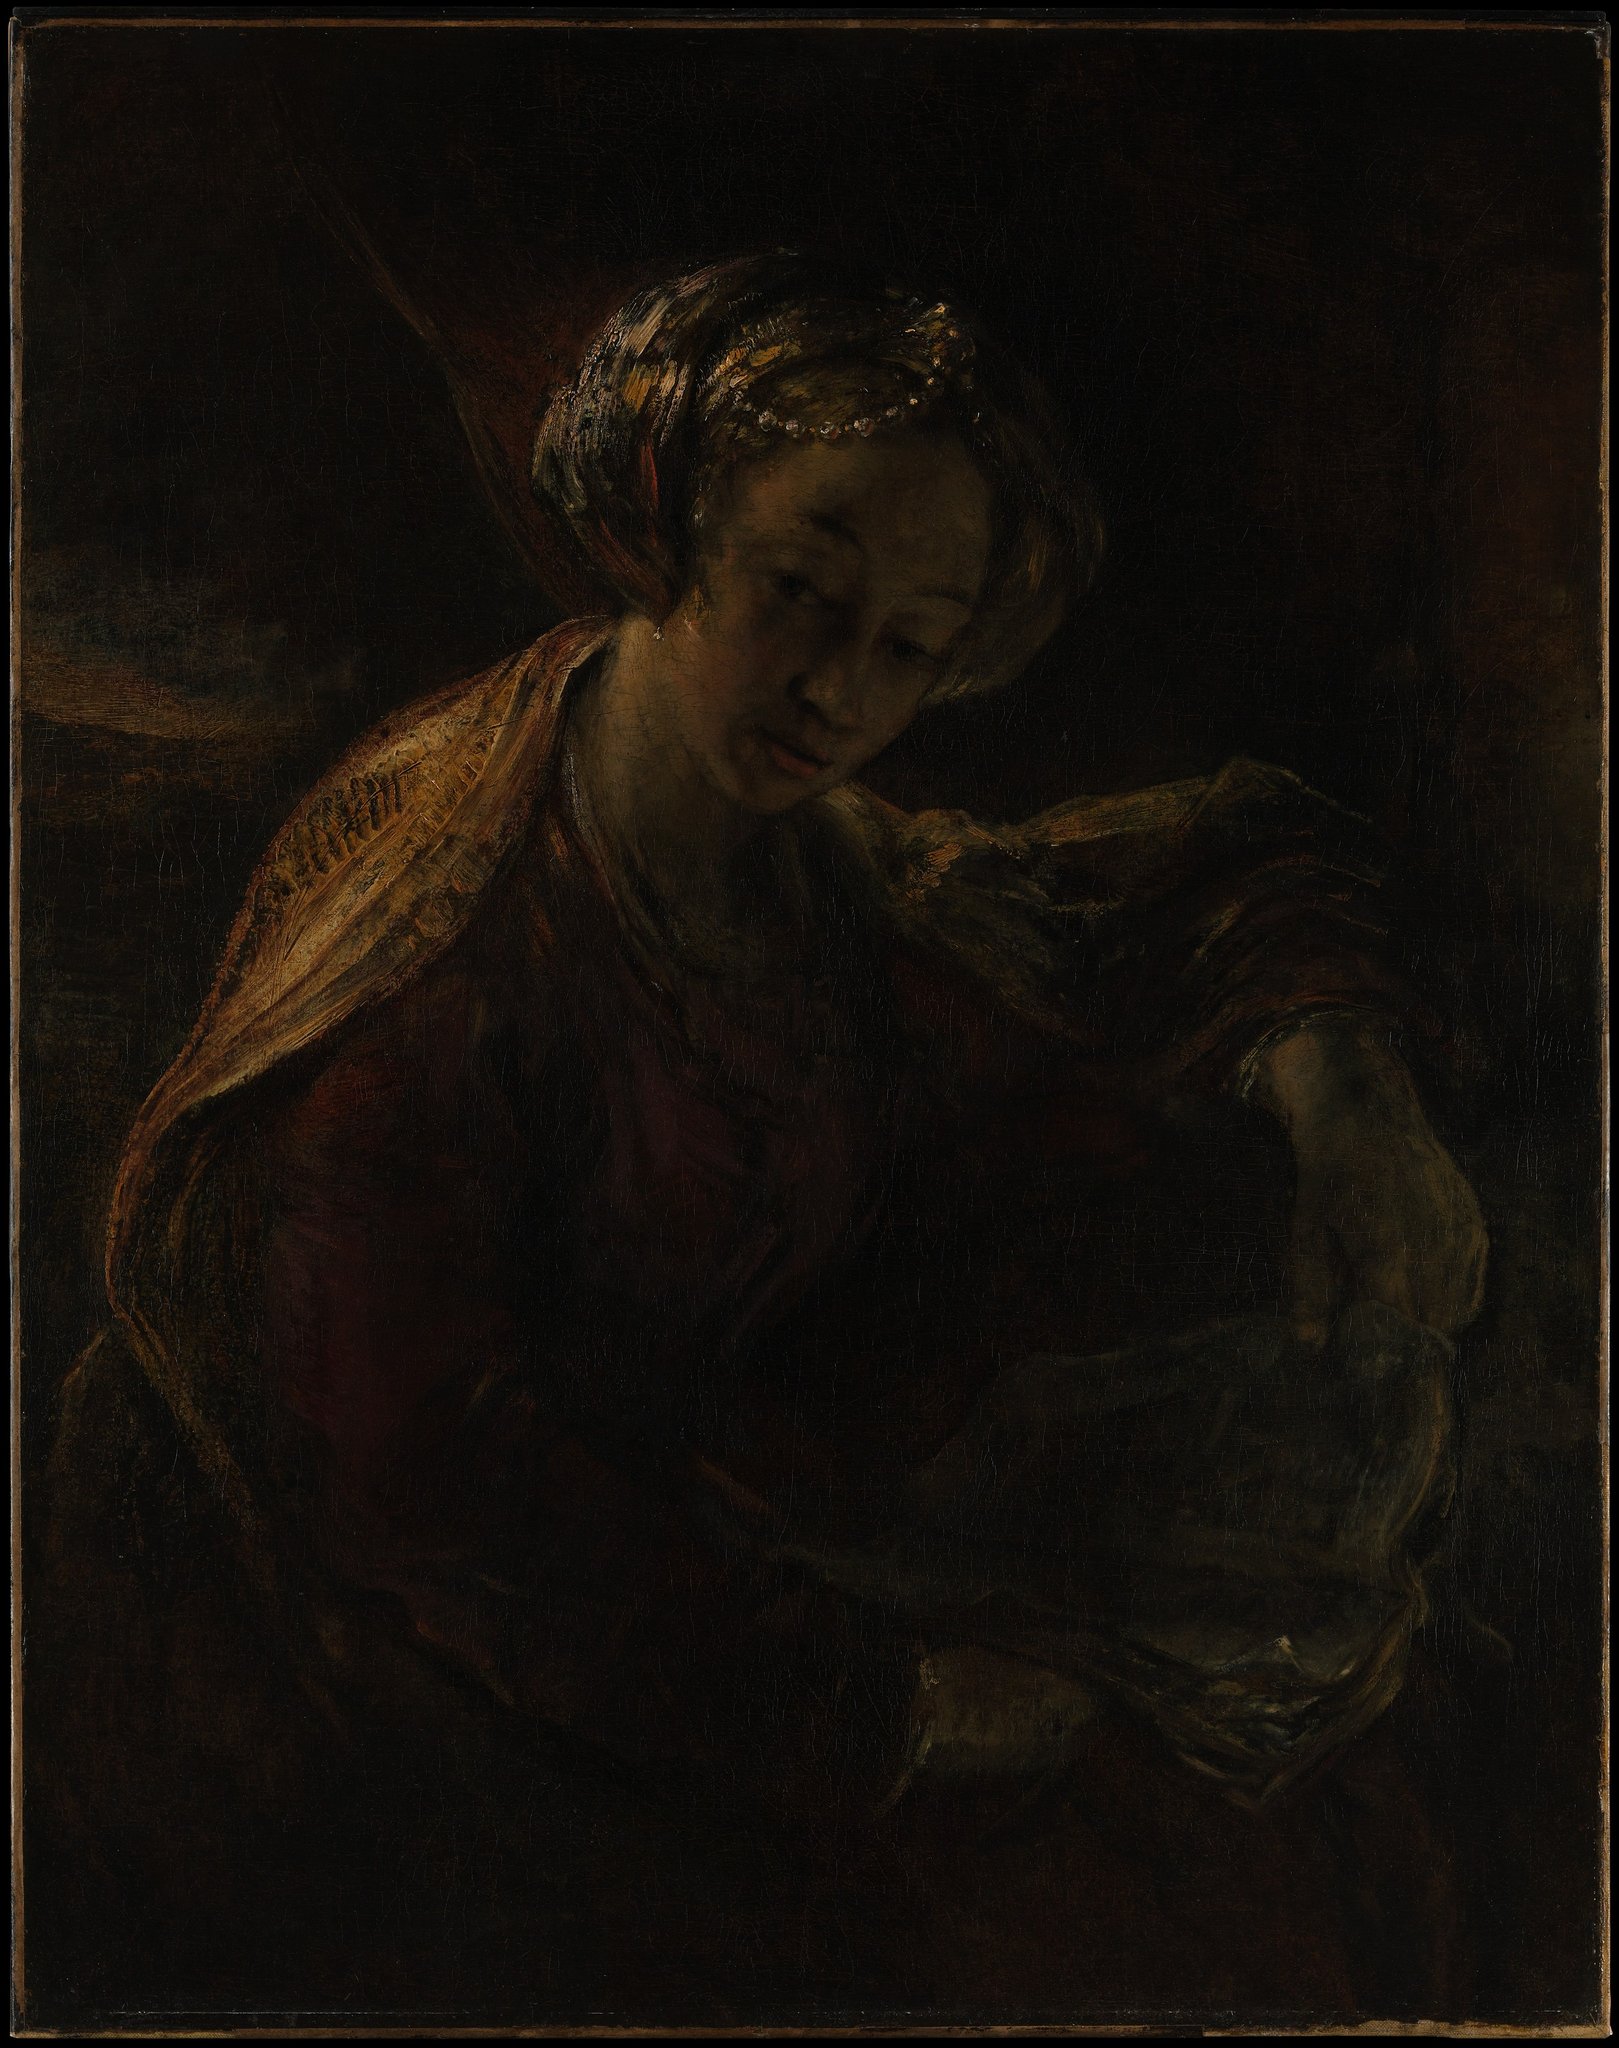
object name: painting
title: The Sibyl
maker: willem drost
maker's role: artist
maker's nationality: dutch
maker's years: 1633-1659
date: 1654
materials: canvas, oil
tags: women,sibyl